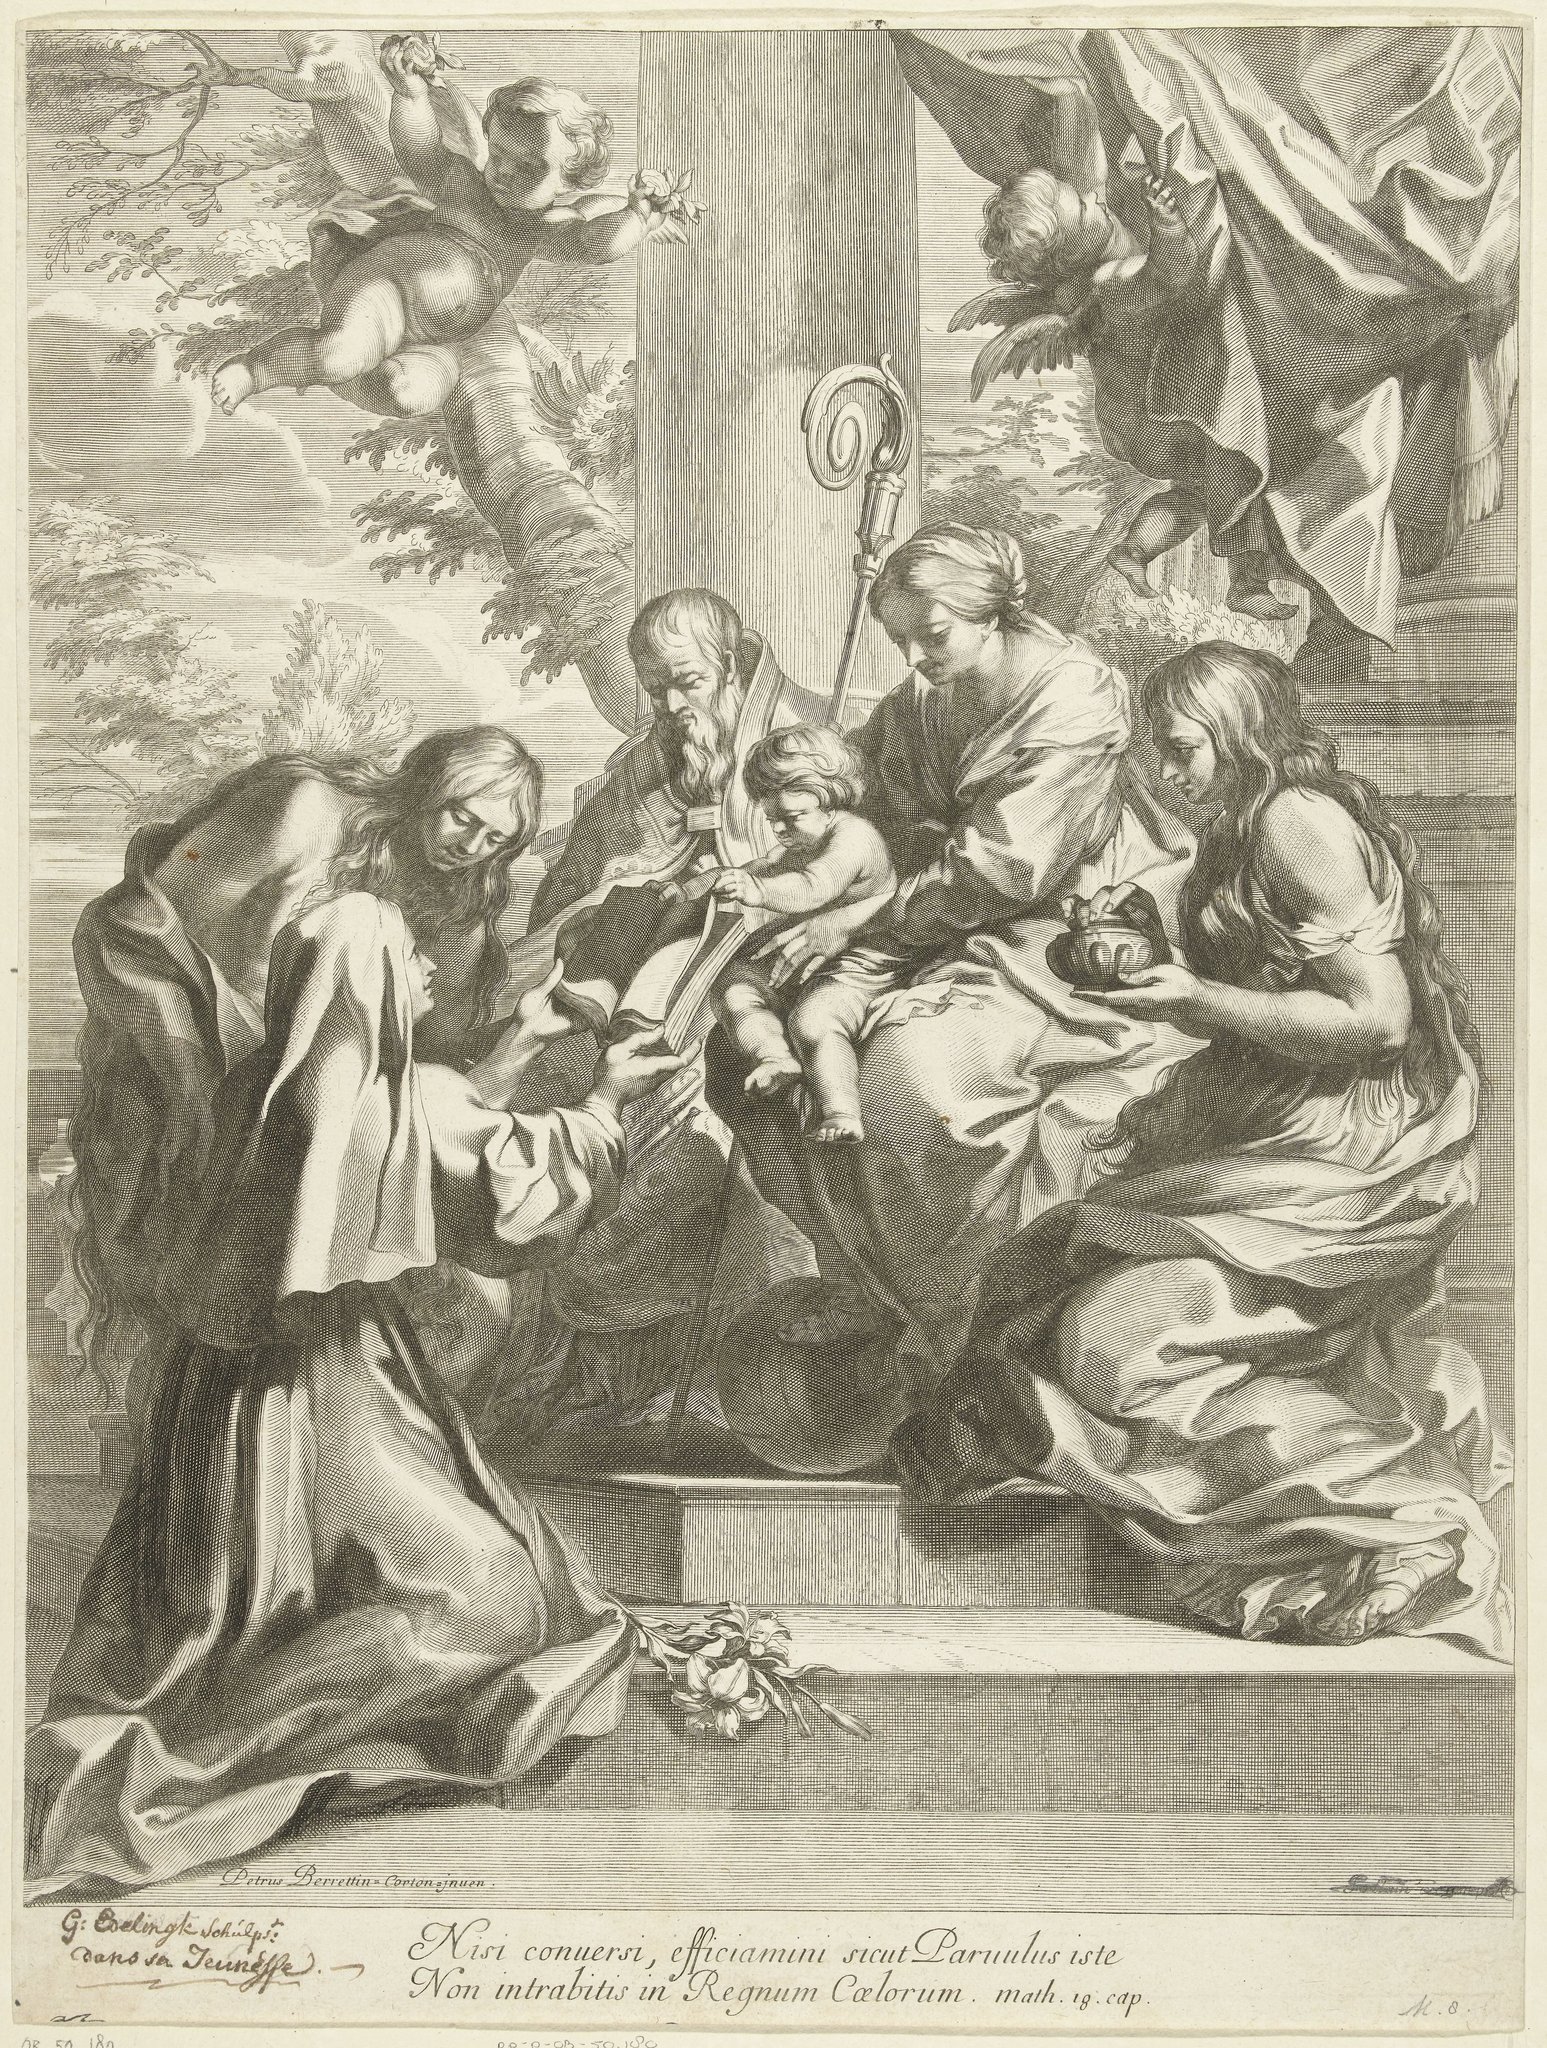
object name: print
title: Heilige Martina aan de voeten van Maria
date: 1666-1707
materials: paper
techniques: engraving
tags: madonna (i.e. mary with the christ-child) accompanied or surrounded by others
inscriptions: collector's mark: Lugt 2135, collector's mark: Lugt 2228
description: De heilige Martina biedt geknield een boek aan aan Maria met het Christuskind op haar schoot. Naast Maria drie andere personen en boven haar twee putti. Onder de voorstelling een onderschrift in Latijn.